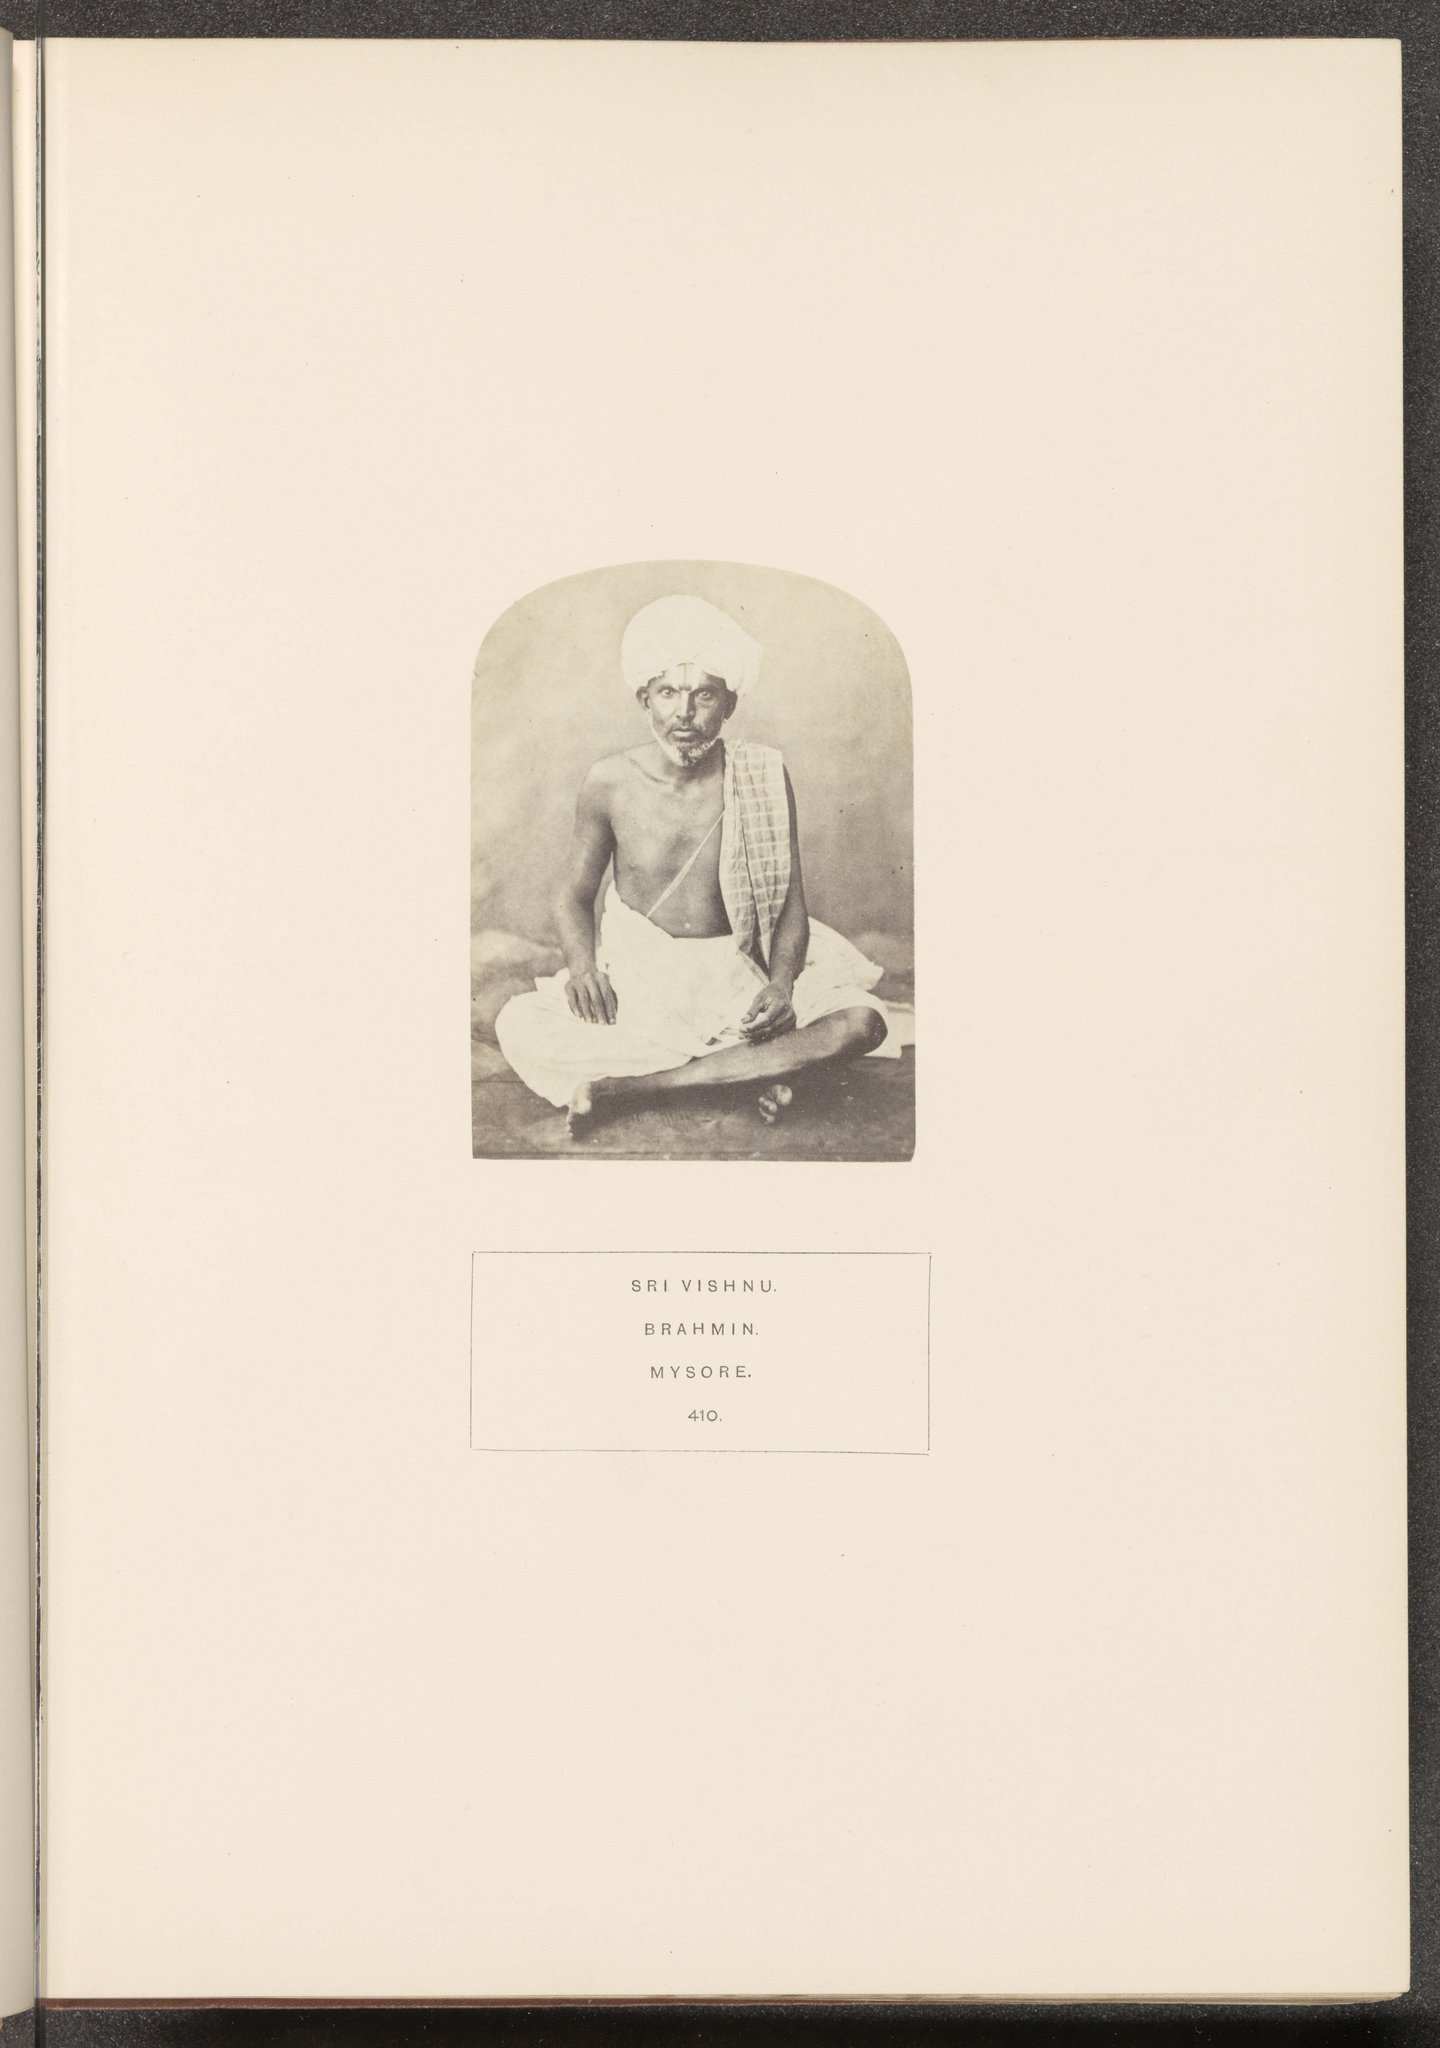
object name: photograph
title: Portrait of an unknown priest from the Vaishnav Brahmin community of Mysore, Karnataka, India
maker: Anonymous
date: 1865-1875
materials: photographic support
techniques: albumen print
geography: mysore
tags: brahma (supreme being, creator, etc. ~ hinduism, buddhism, jainism), human races; peoples; nationalities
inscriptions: inscription: ‘SRI VISHNU./ BRAHMIN./ MYSORE.’, number: ‘410.’